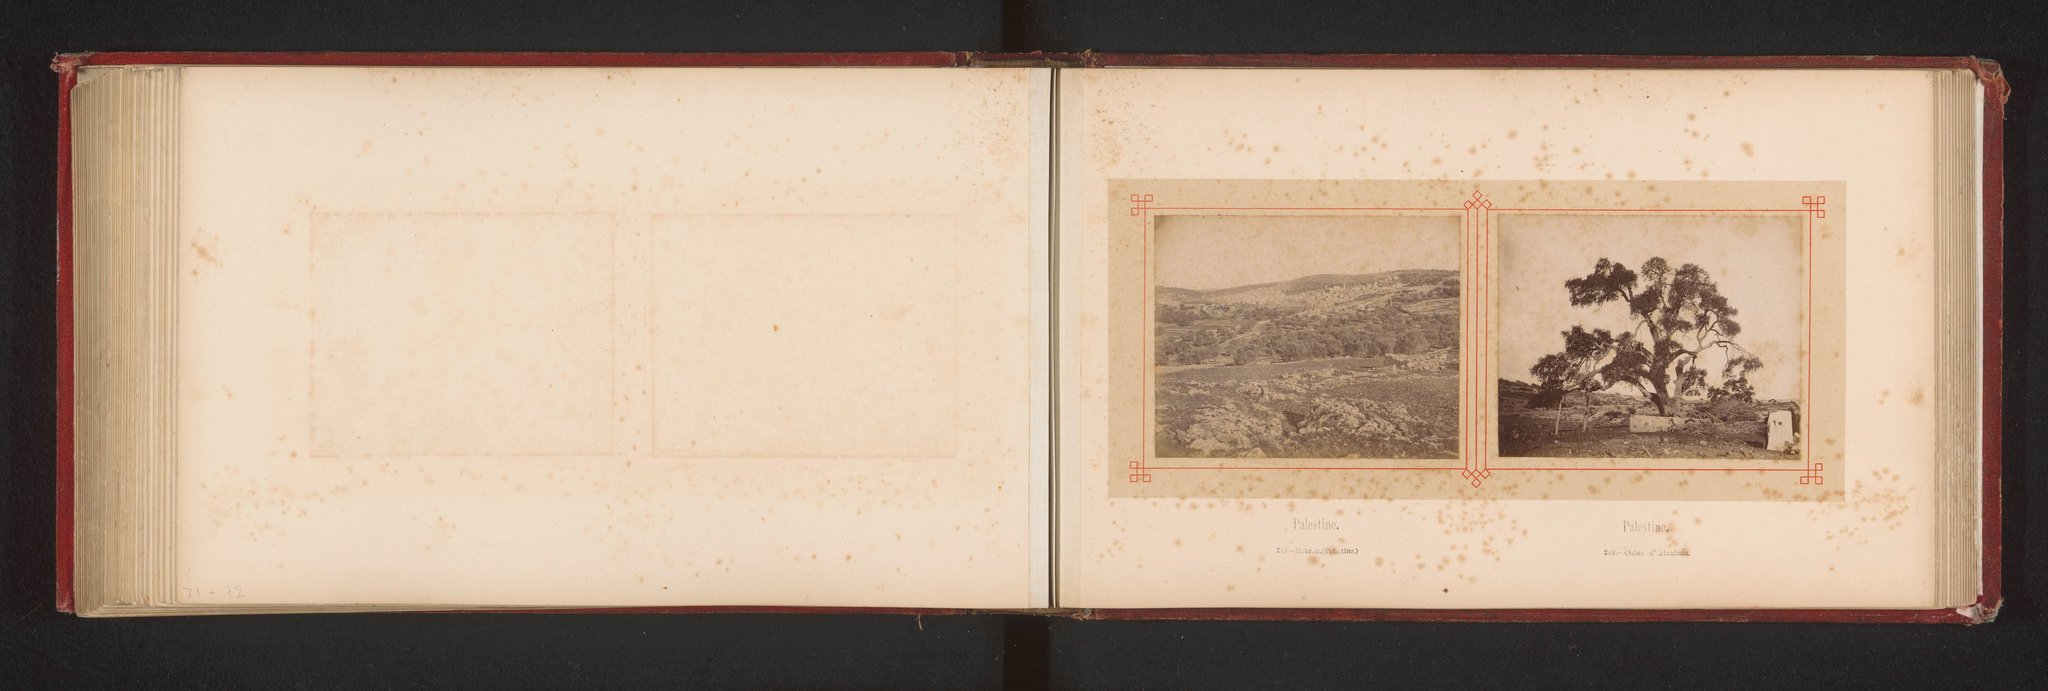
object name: photograph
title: Gezicht op de eik van Abraham ofwel de eik van Mamre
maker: félix bonfils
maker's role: fotograaf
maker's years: 1831-1885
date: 1873-1878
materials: photographic support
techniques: albumen print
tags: trees